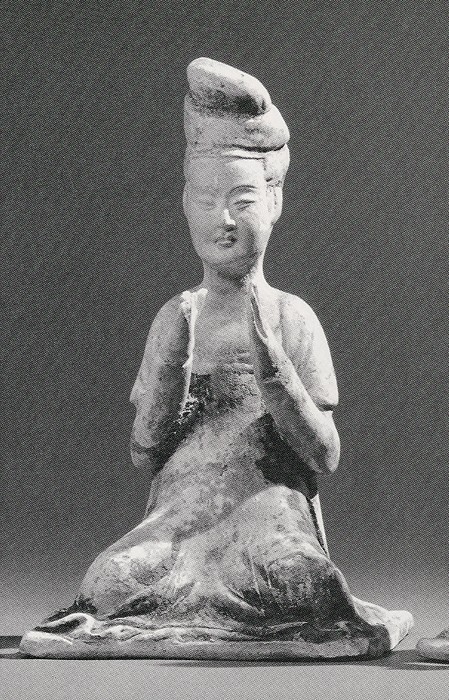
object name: figure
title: Female musician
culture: chinese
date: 667-700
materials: earthenware, pigment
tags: women,musicians